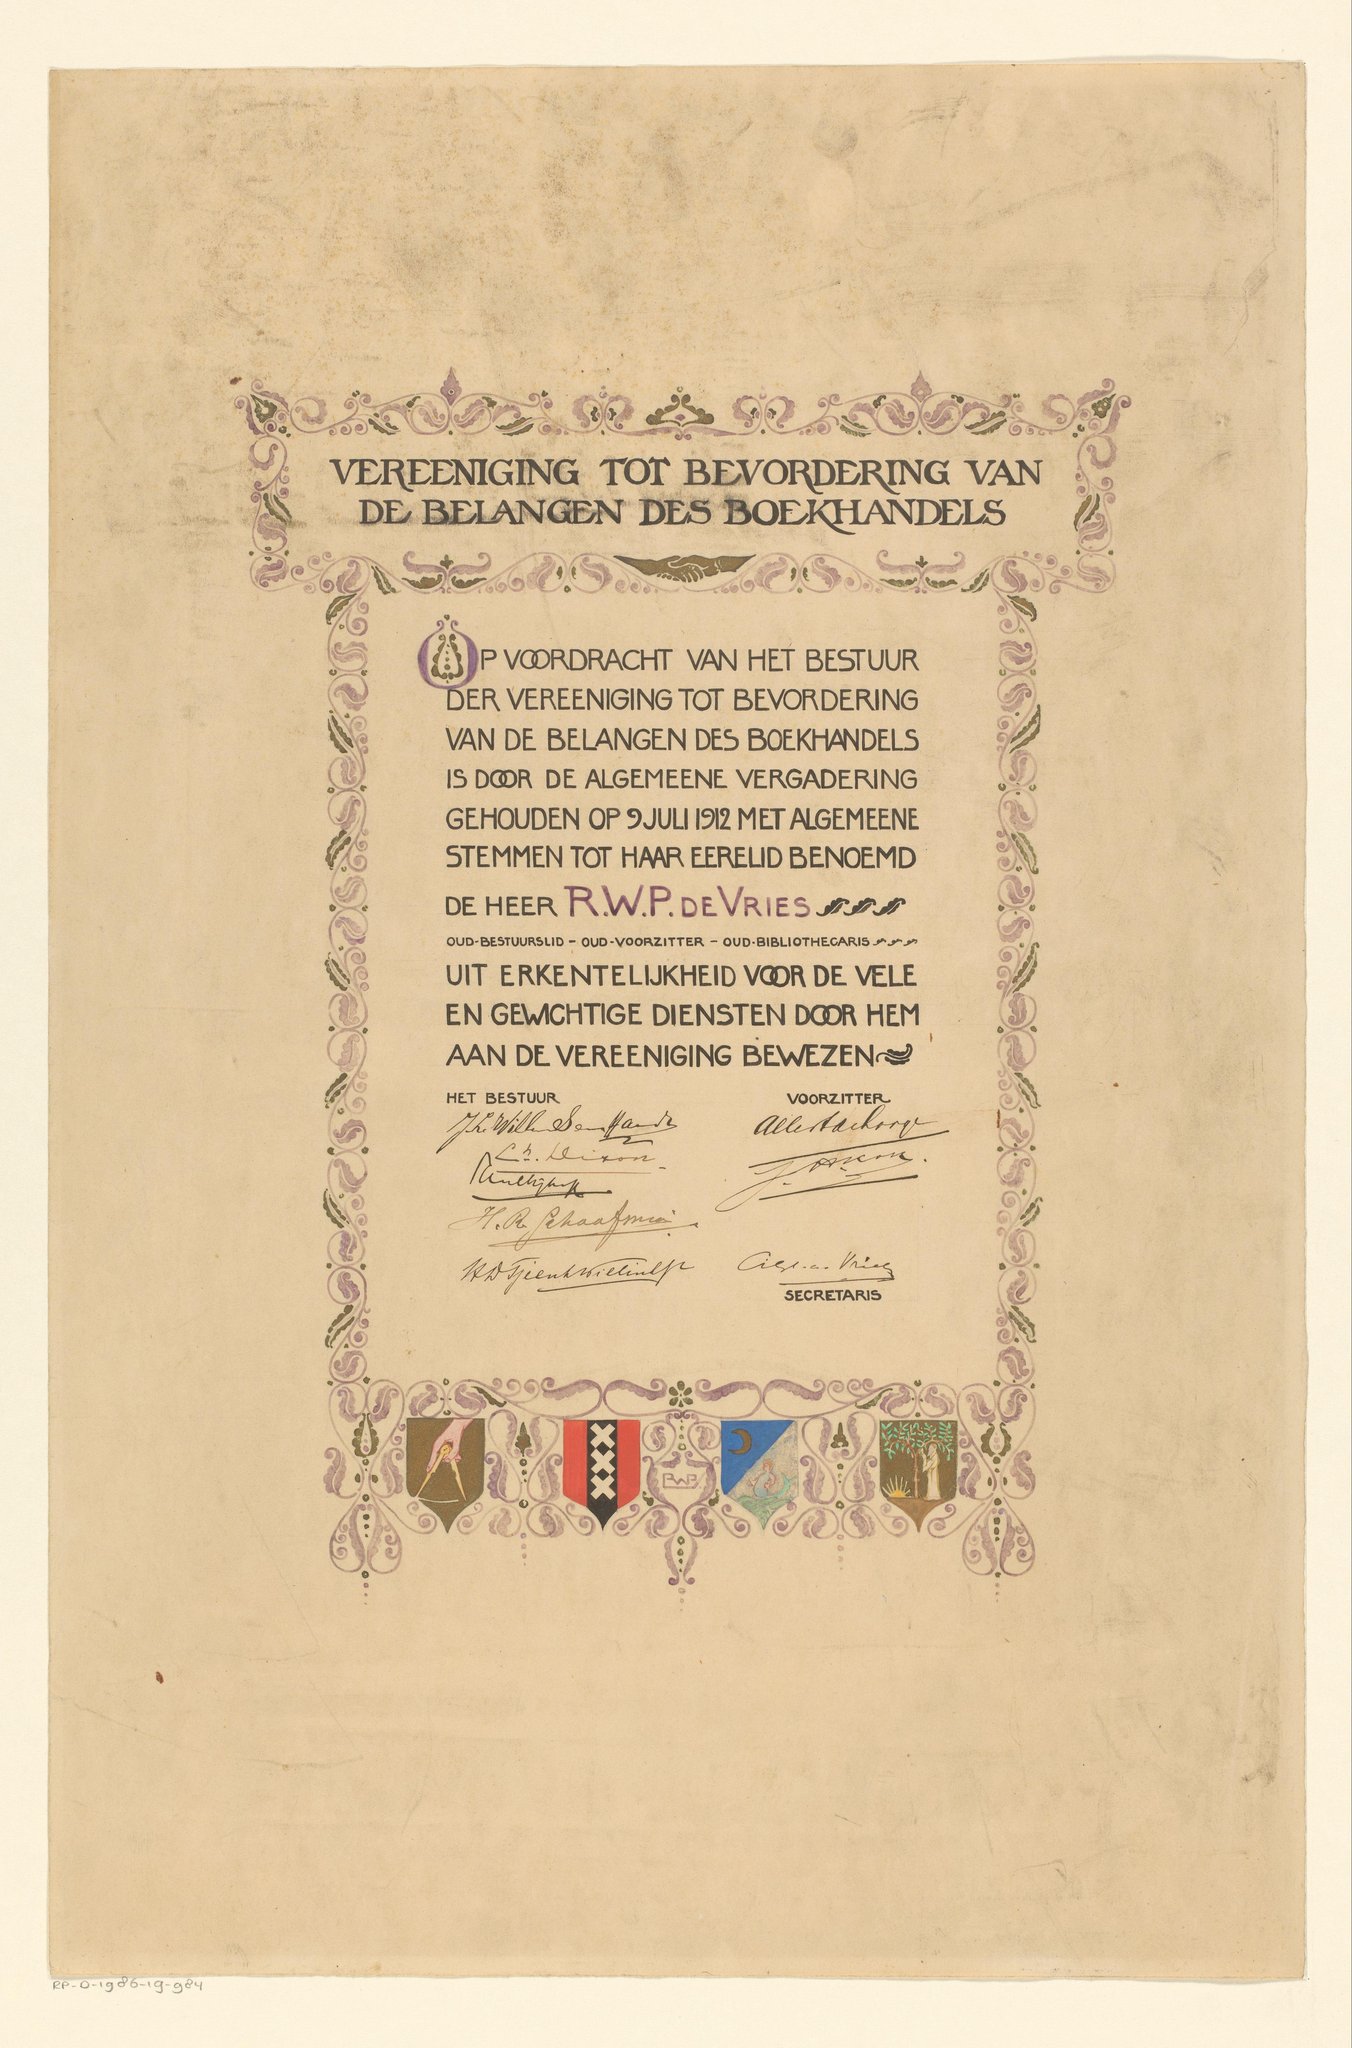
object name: drawing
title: Ontwerp voor een oorkonde van de Vereniging ter Bevordering van de Belangen des Boekhandels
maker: reinier willem petrus de vries (1874-1953)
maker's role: draughtsman, print maker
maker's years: 1874-1953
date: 1912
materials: paint, ink, paper, pencil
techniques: brush, pen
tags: coat of arms (as symbol of the state, etc.) (+ city; municipal), flowers ~ ornament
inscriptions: collector's mark: ‘R:MVS.’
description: Oorkonde met kader met bloemornamenten en wapens. De oorkonde was bedoeld voor R.W.P. de Vries (1841-1919), de vader van de kunstenaar.